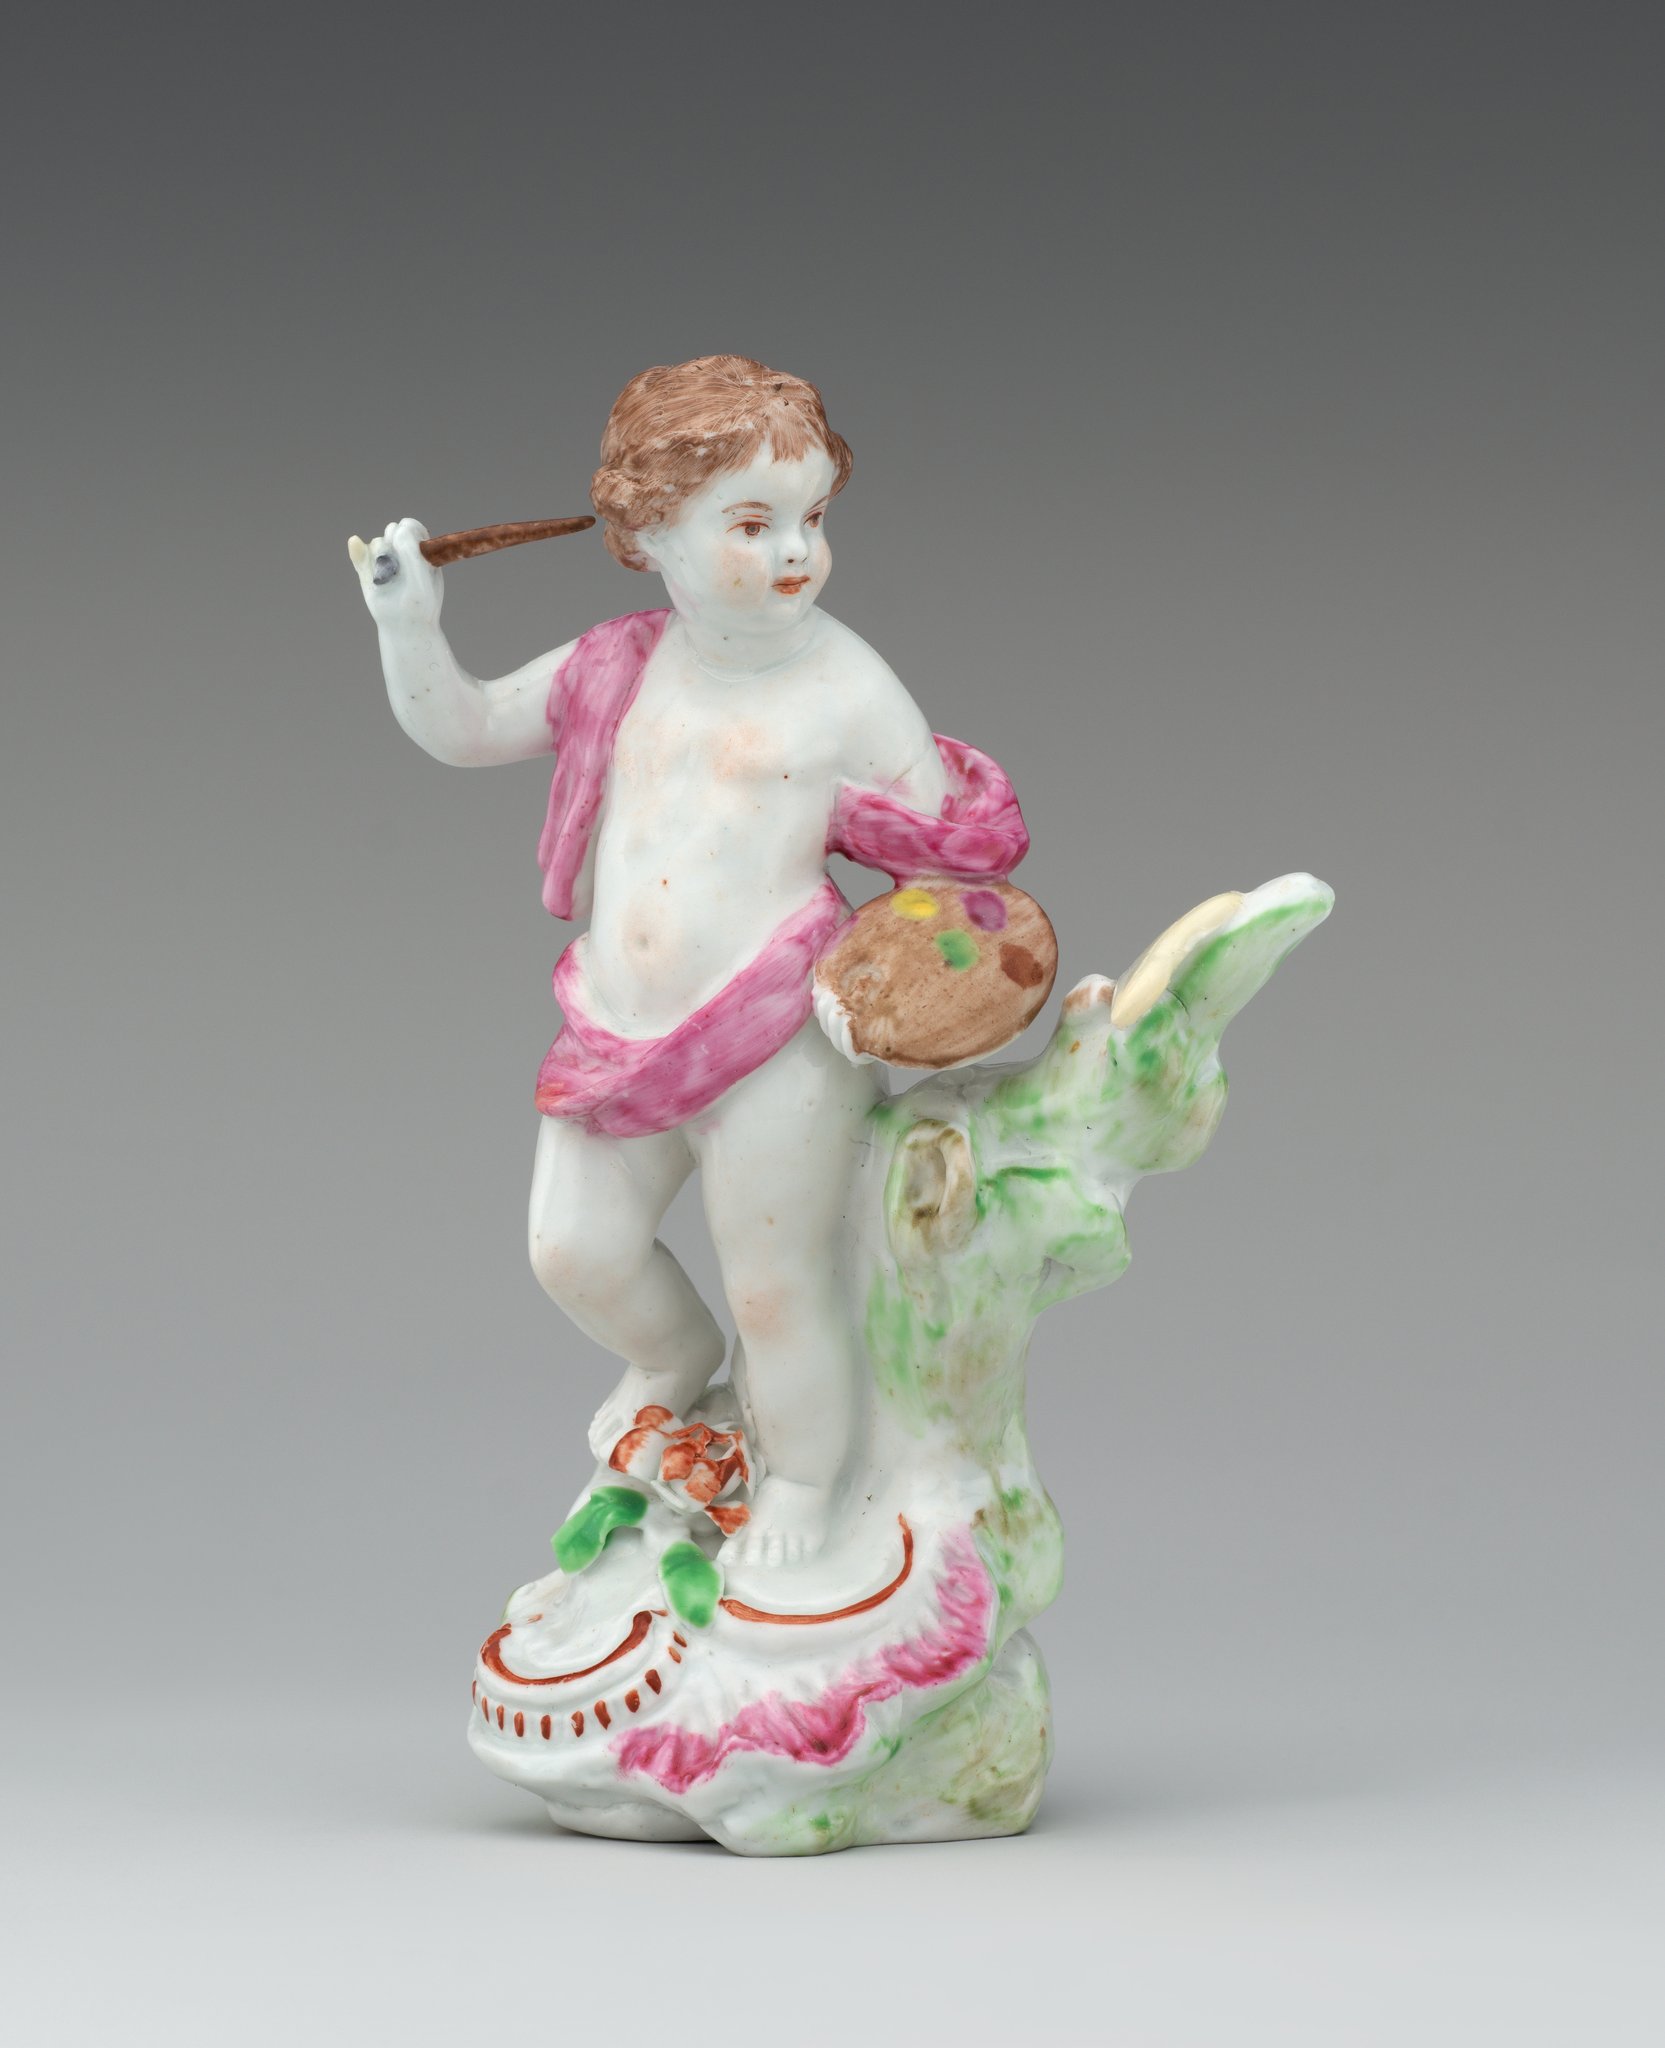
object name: figure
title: Figure personifying Painting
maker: vauxhall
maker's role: factory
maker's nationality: british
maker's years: 1748-1768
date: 1755-1758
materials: soft paste porcelain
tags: painting,children,palettes